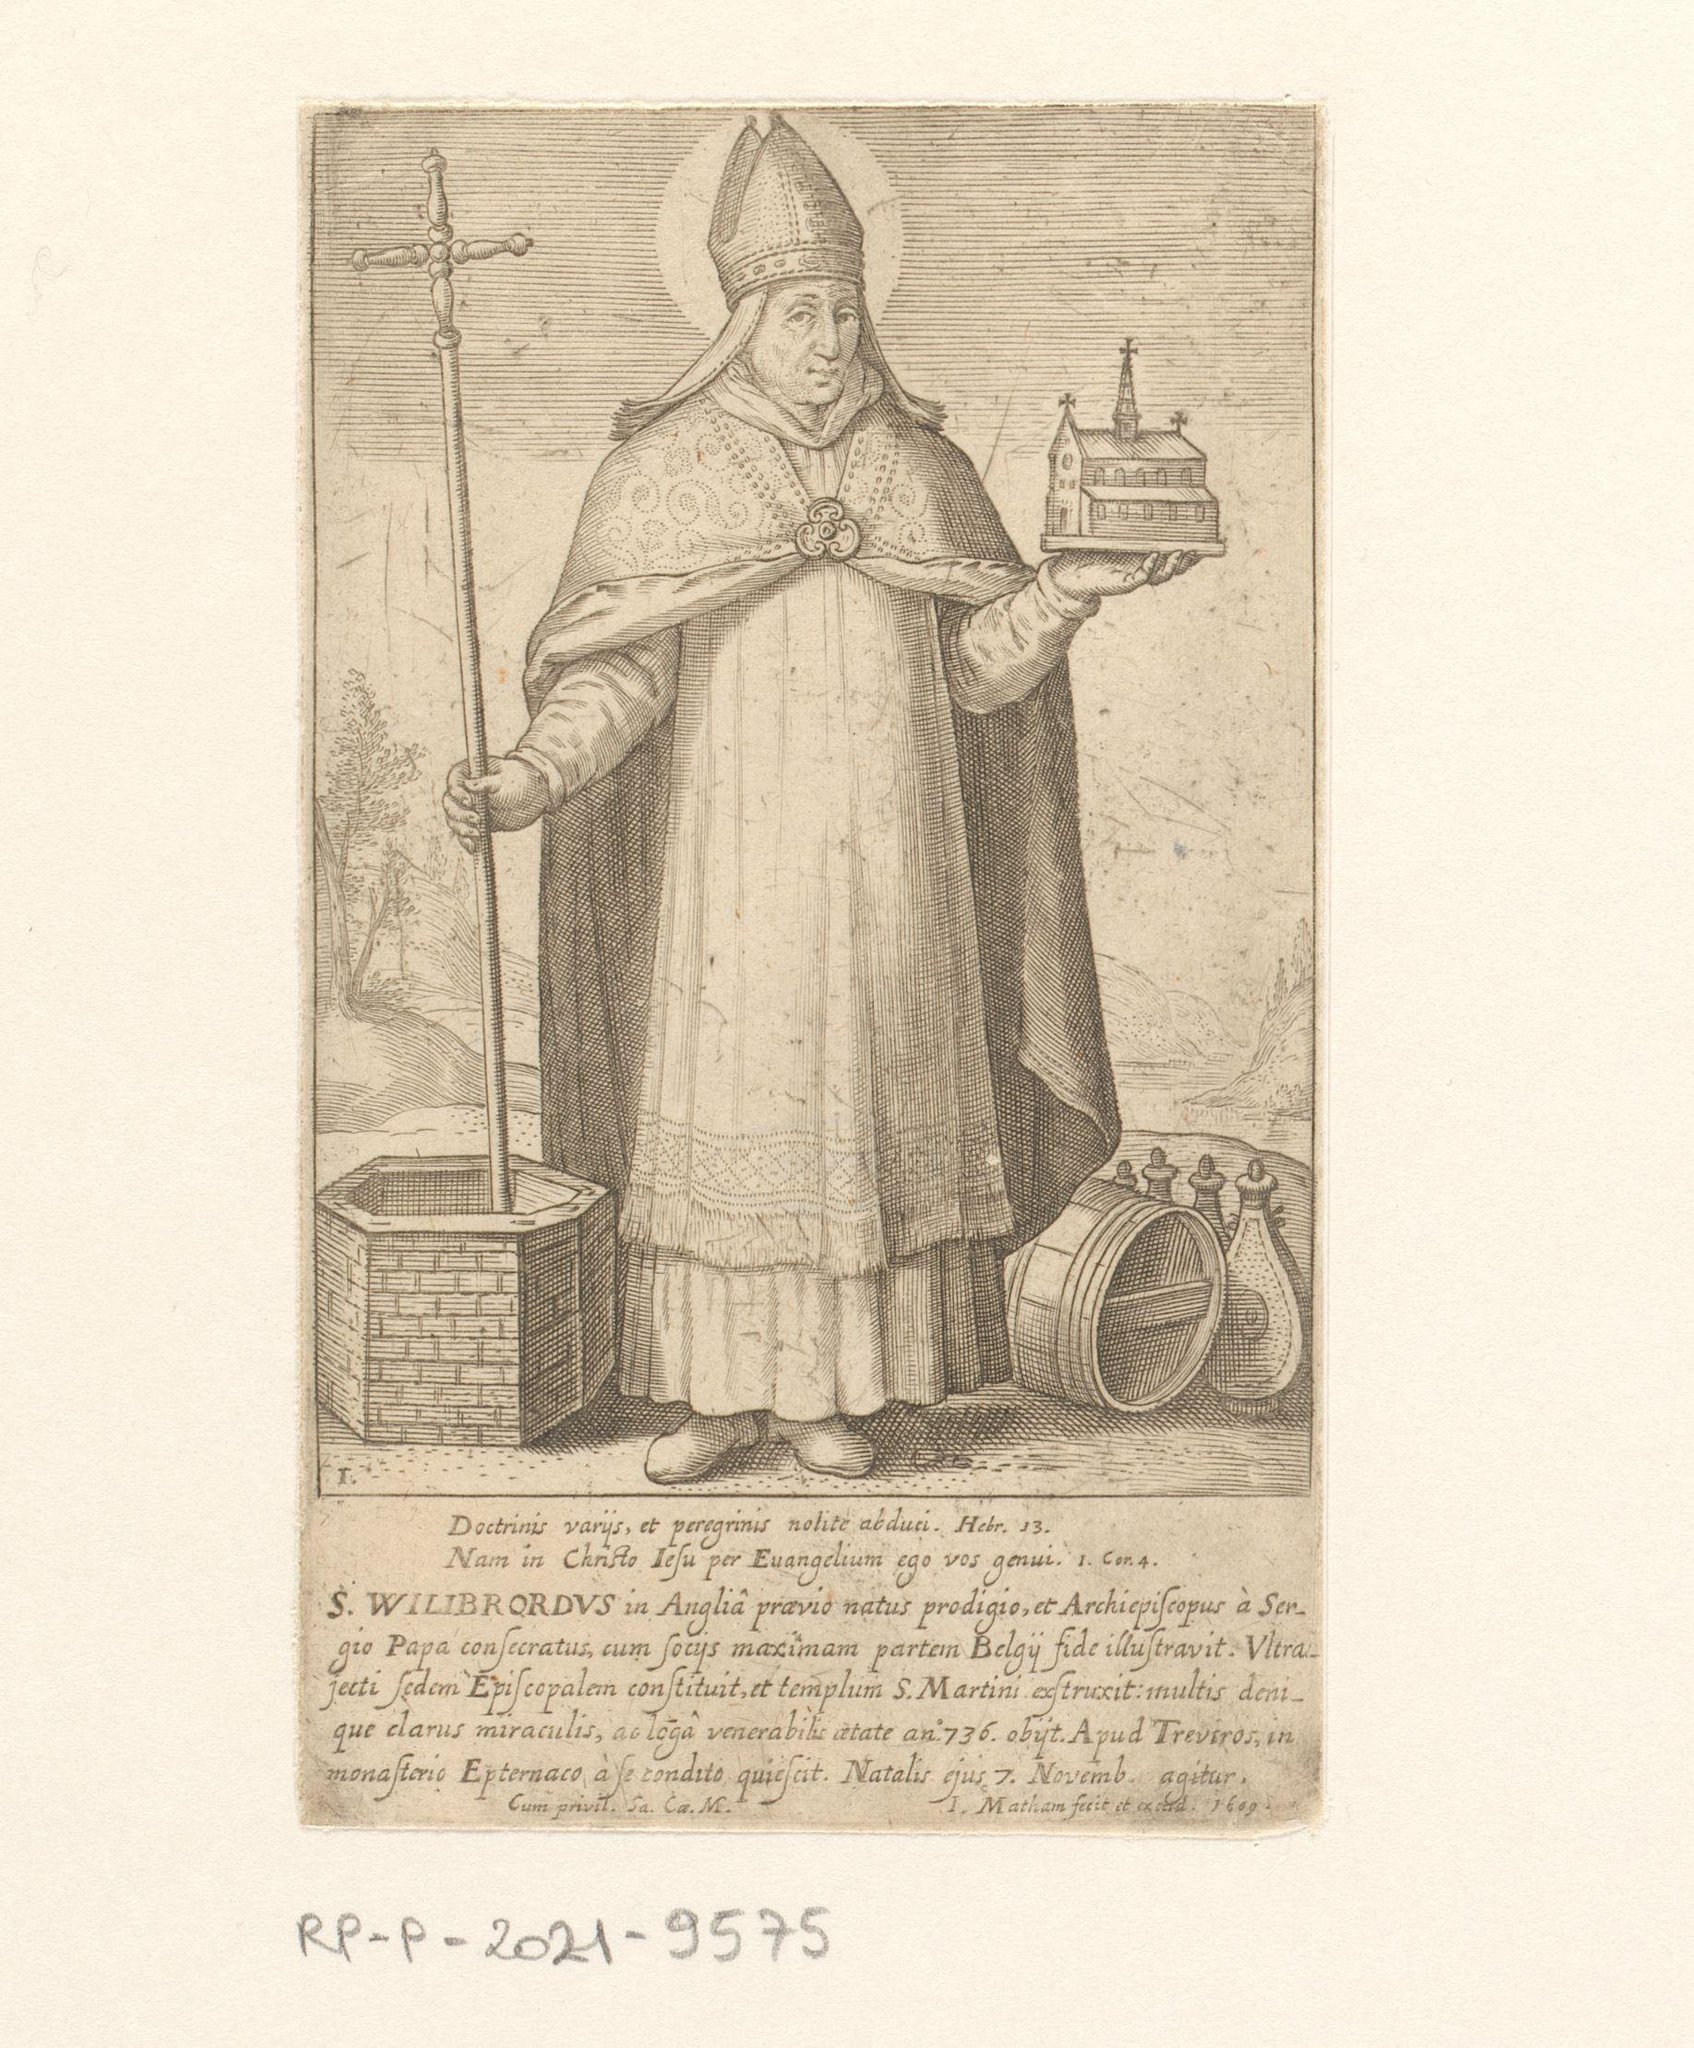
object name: print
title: Heiligen vereerd in Haarlem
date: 1609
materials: paper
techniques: engraving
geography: haarlem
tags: the 'apostle of frisia' and archbishop of utrecht, willibrord (of echternach); possible attributes: cask (barrel), well (fountain), child (on a book), model of church, stone bottles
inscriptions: collector's mark: Lugt 2228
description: De heilige Willibrord, aartsbisschop van Utrecht. met bisschopsmijter en staf, in de linkerhand een model van dom van Utrecht. Links een bron (put) en rechts een wijnvat en flessen. Linksonder genummerd: 1. Met twee regels Bijbeltekst en vijf regels biografie in het Latijn.